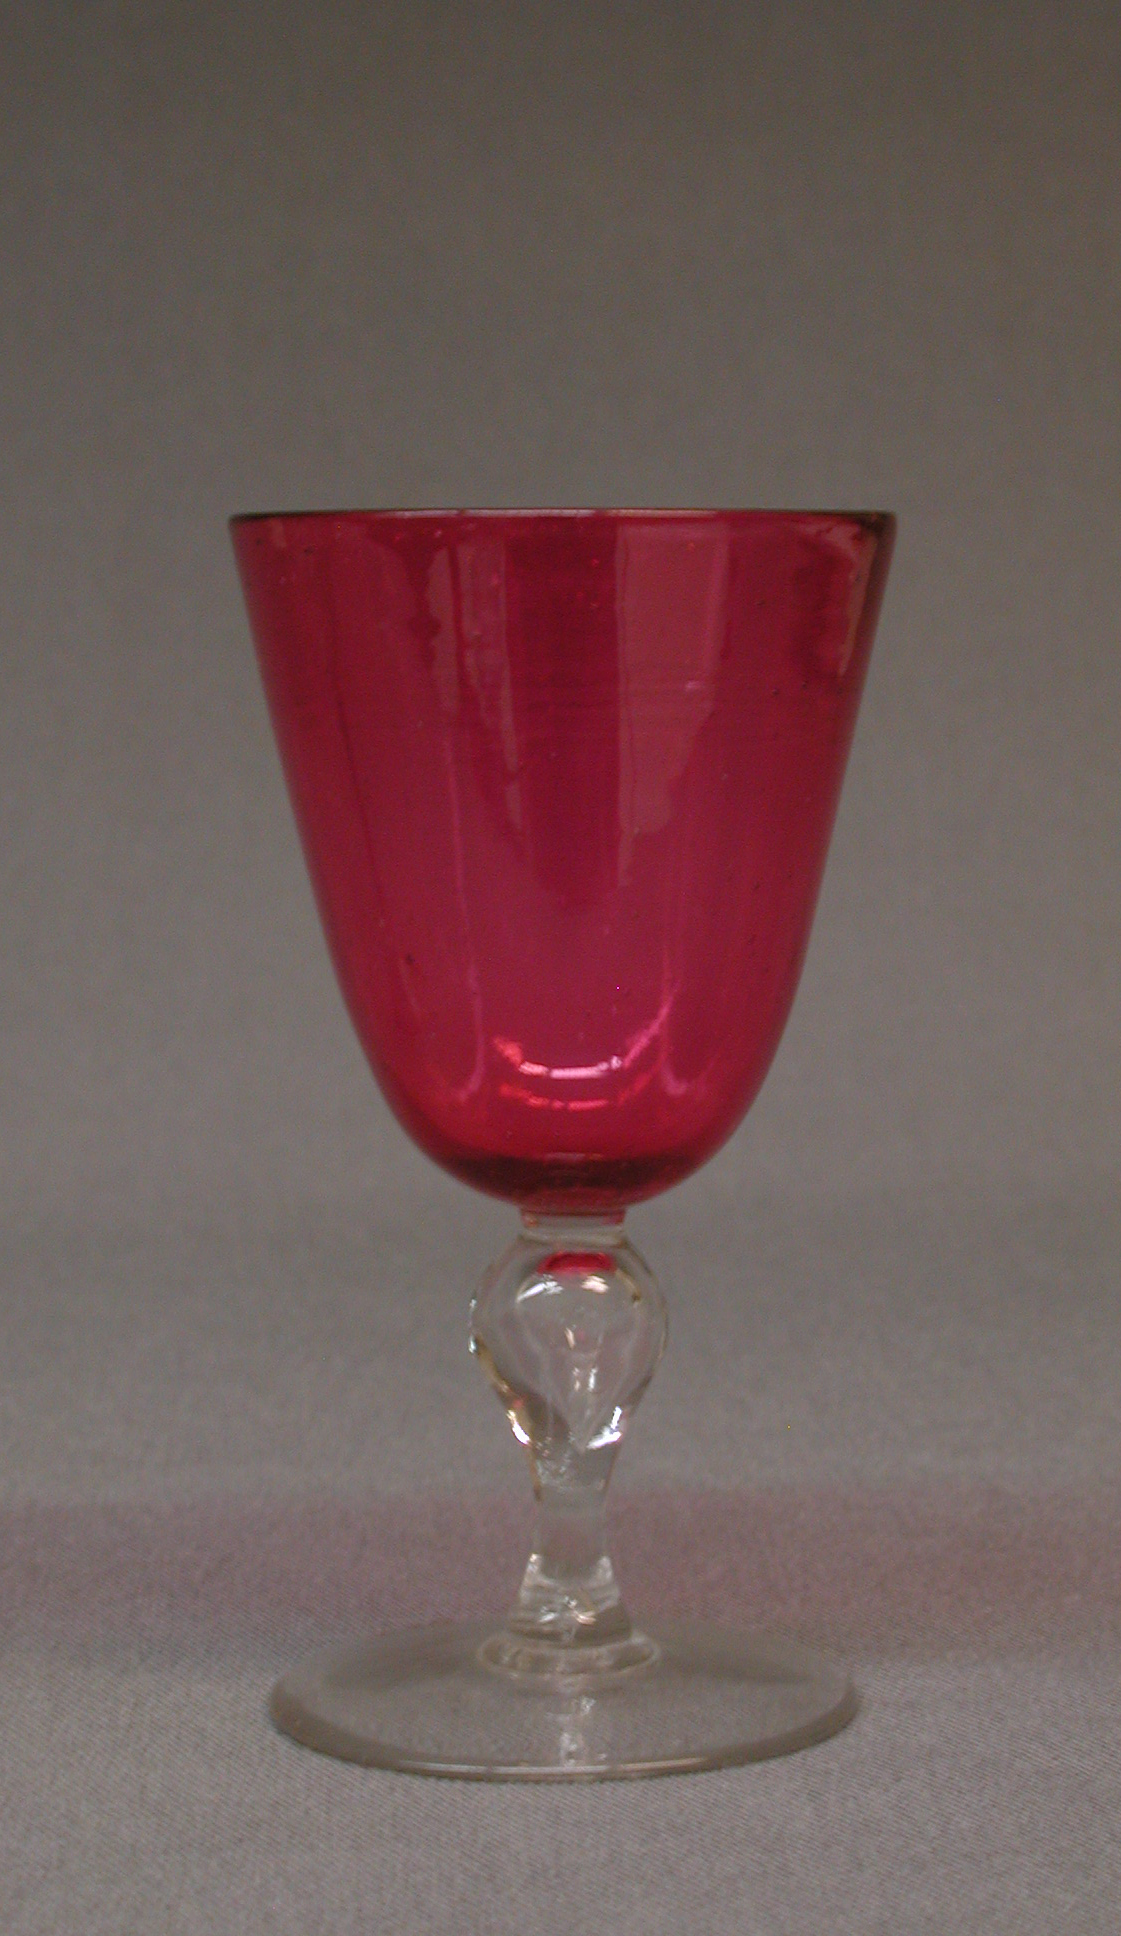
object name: wineglass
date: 1867-1900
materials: glass